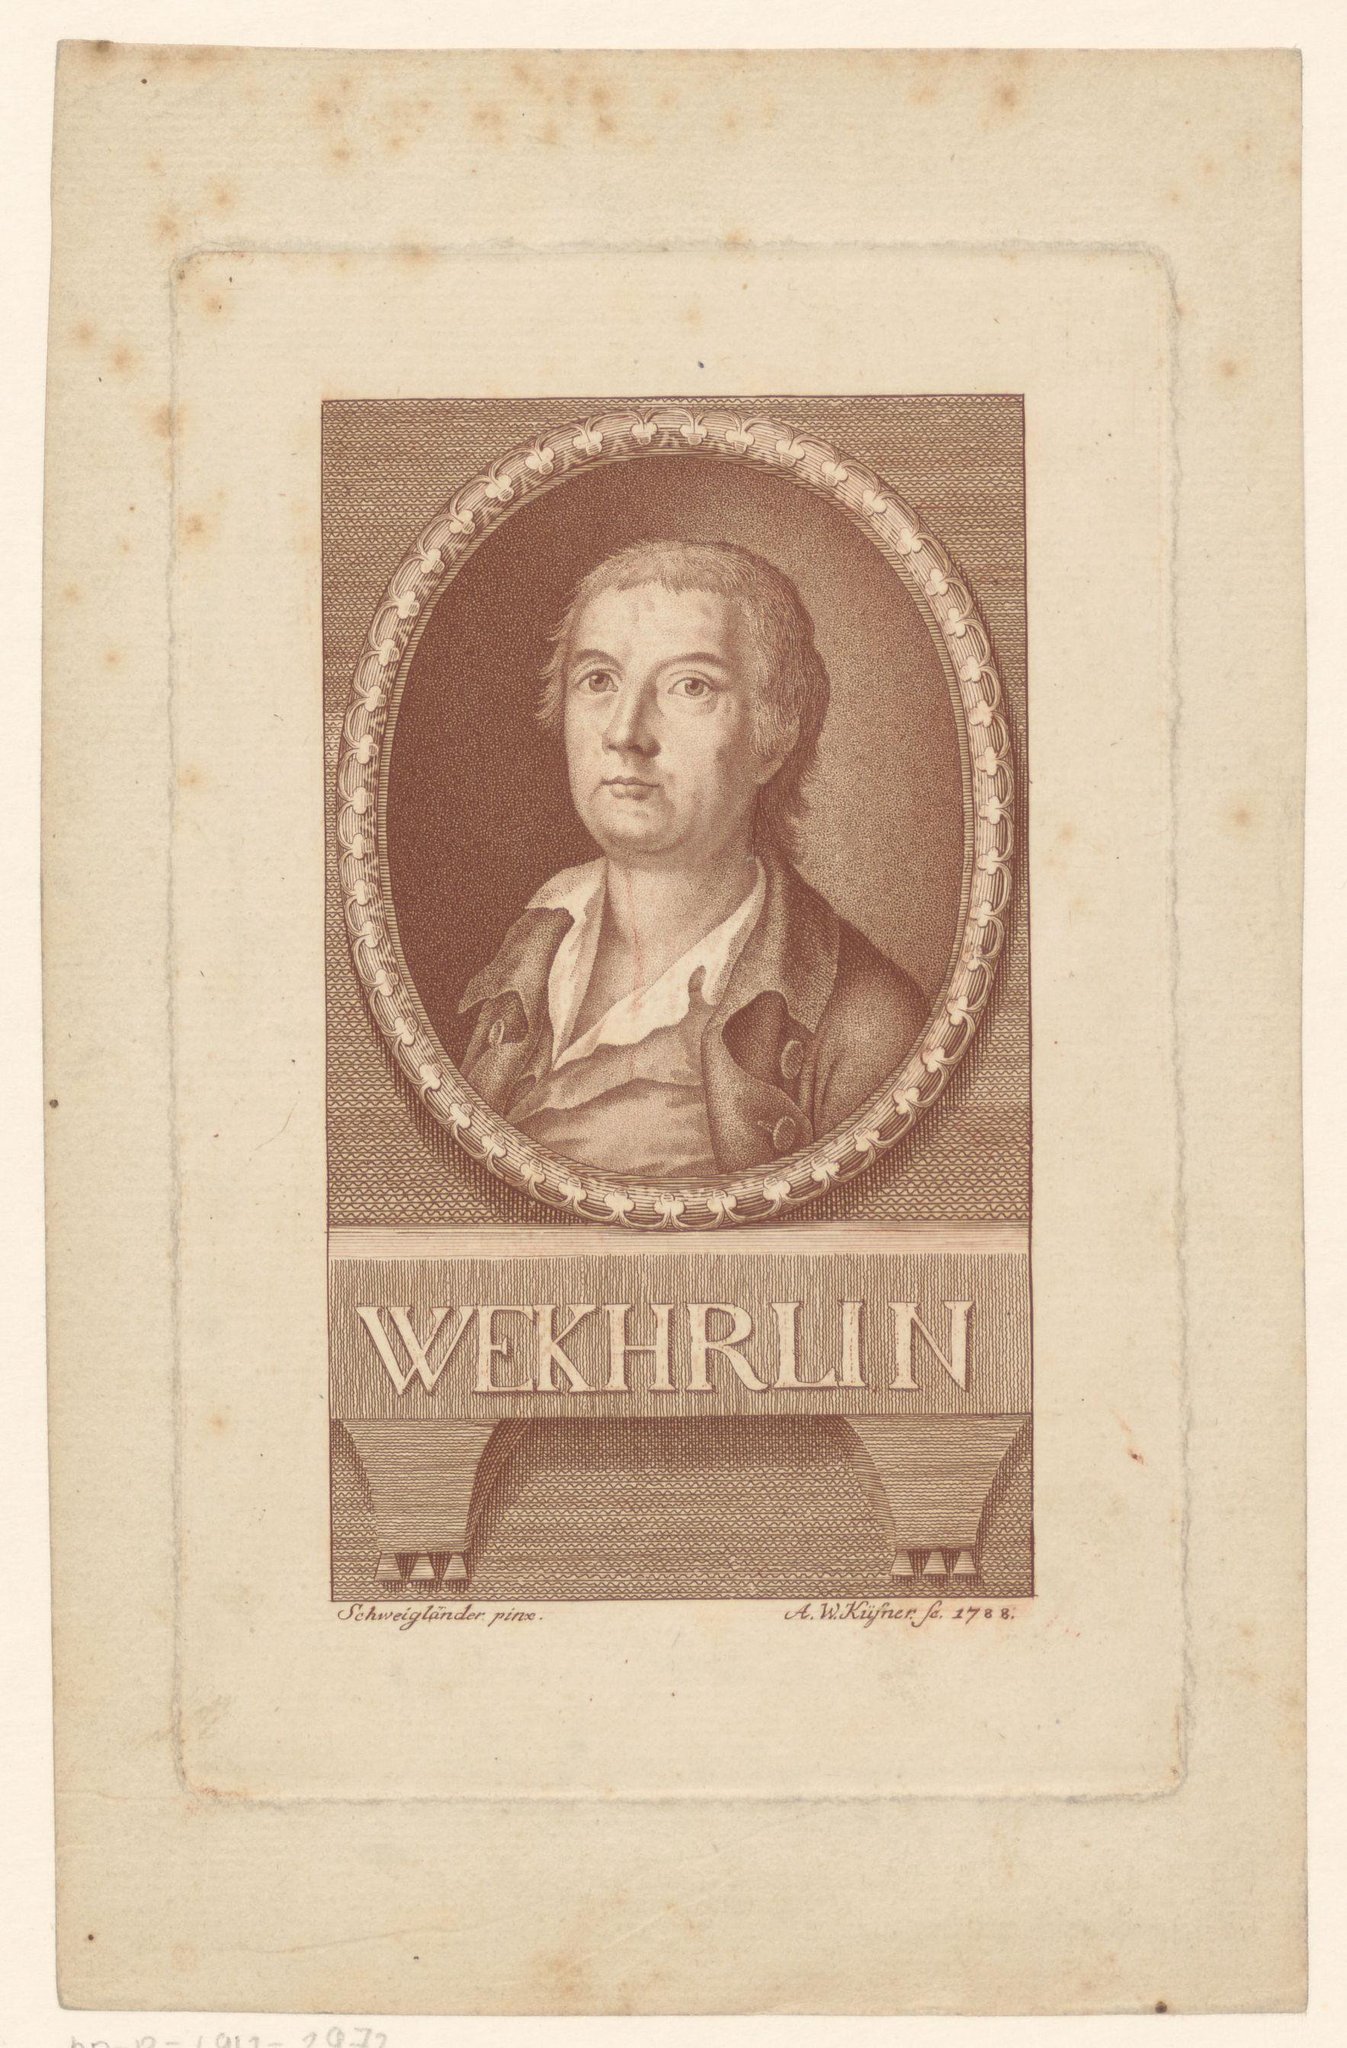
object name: print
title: Portret van Wilhelm Ludwig Wekhrlin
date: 1788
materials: paper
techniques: etching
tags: publisher, historical persons, portrait of a writer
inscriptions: collector's mark: Lugt 2228